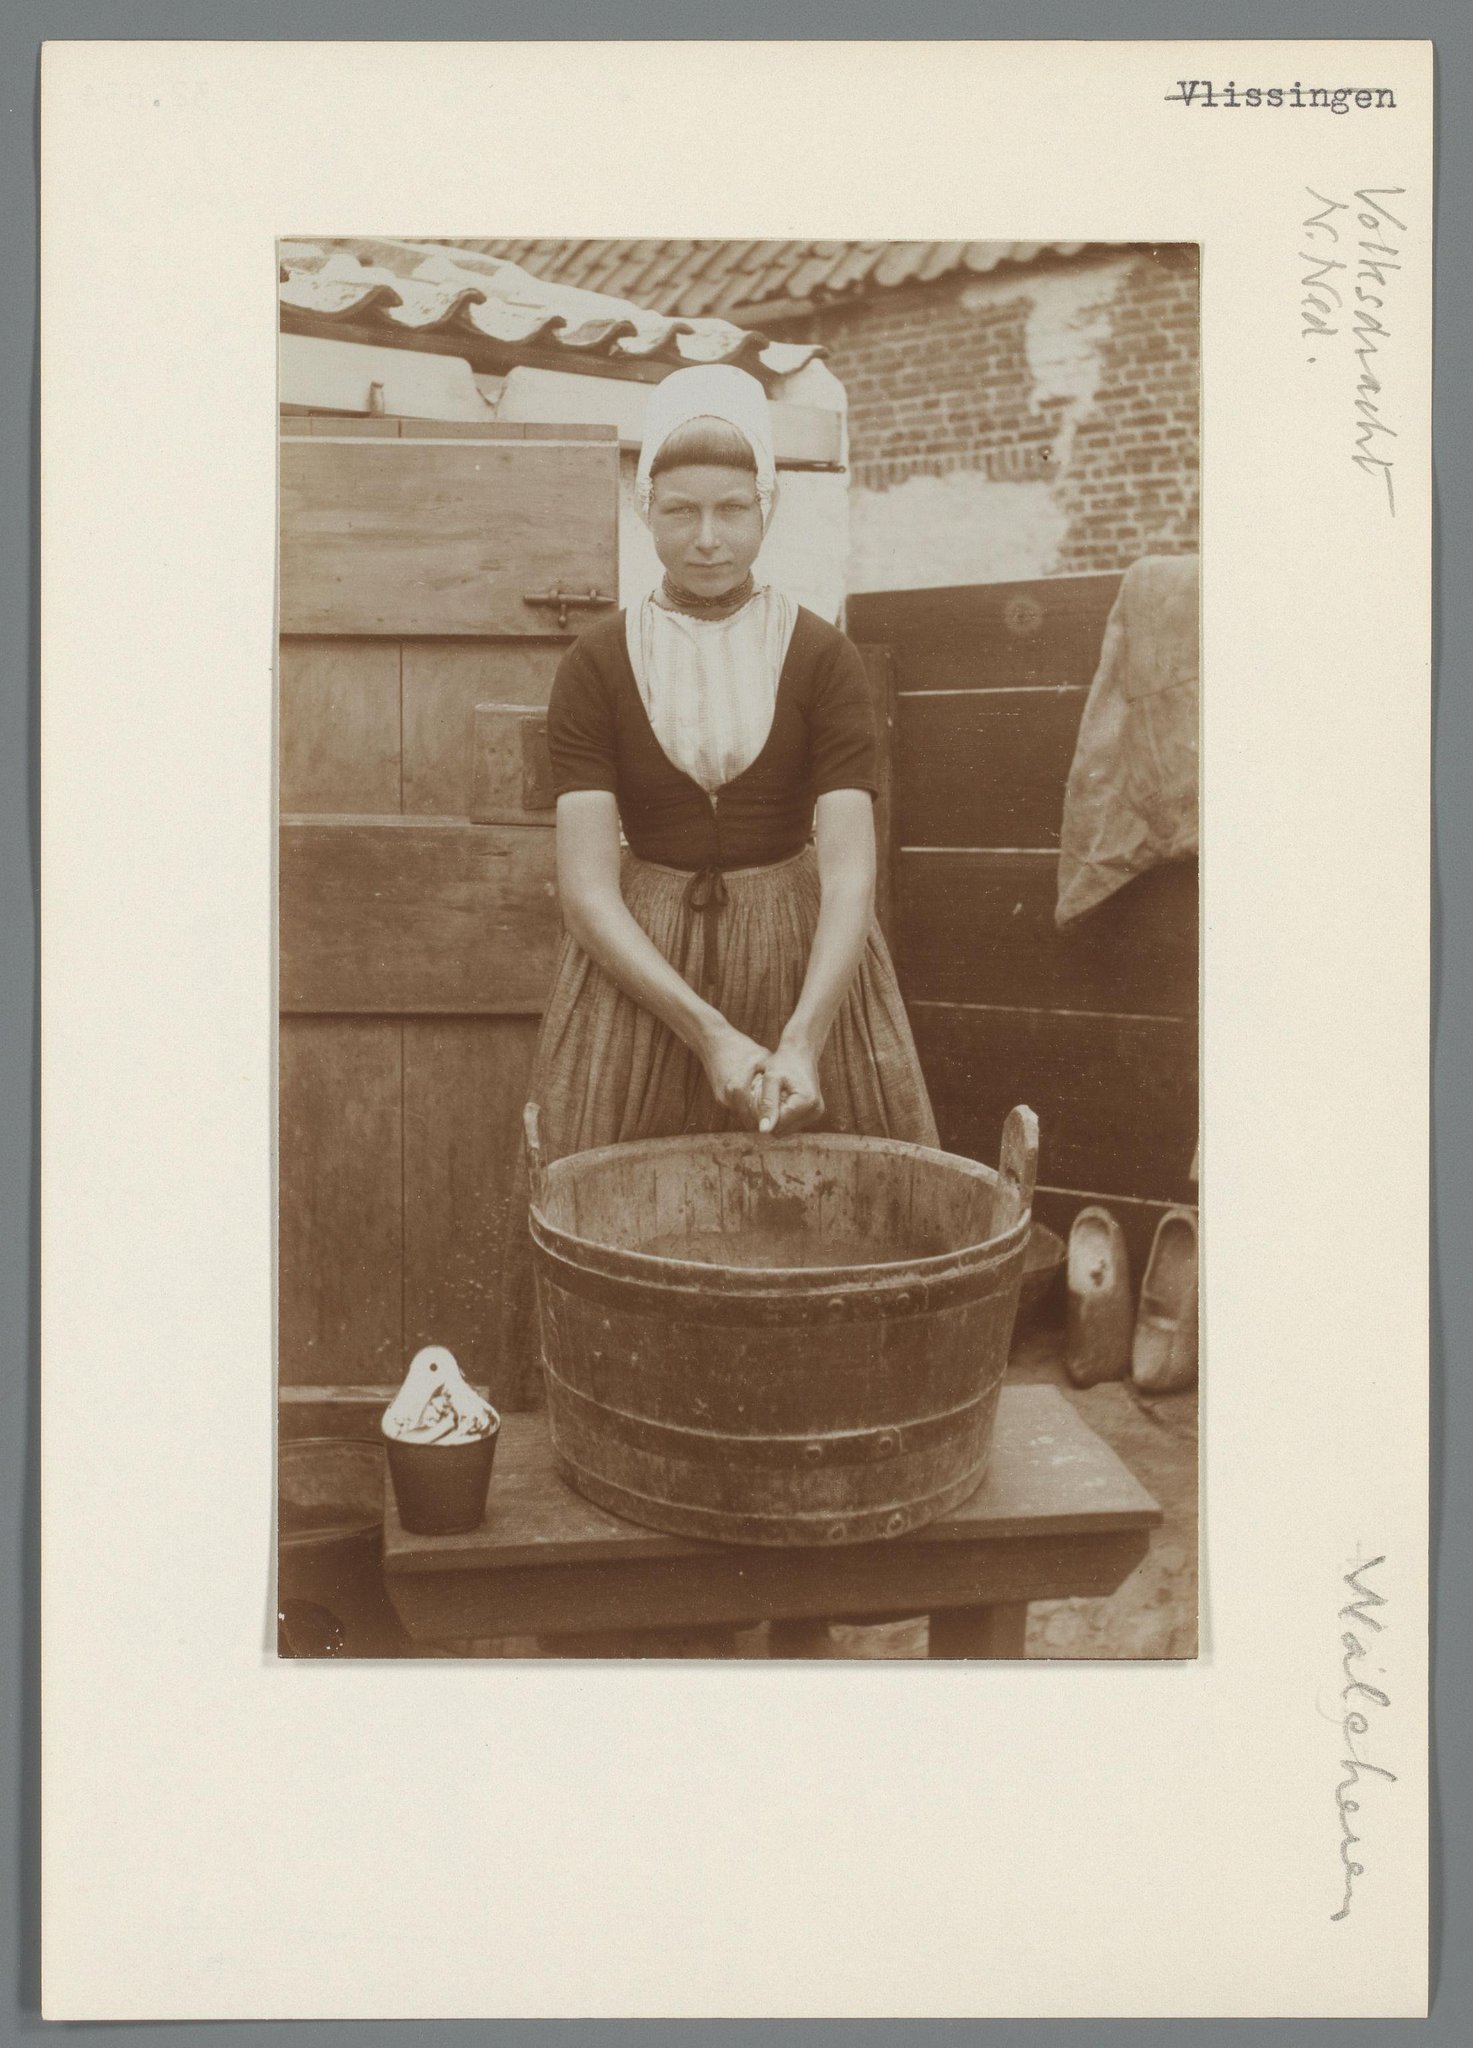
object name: photograph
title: Vlissingen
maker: Anonymous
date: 1880-1920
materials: paper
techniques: collodion silver print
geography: walcheren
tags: historical persons, laundering, folk costume, regional costume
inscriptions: inscription: ‘Volksdracht/ N.Ned./ Walcheren’, number: ‘- 527078’, number: ‘32.834’